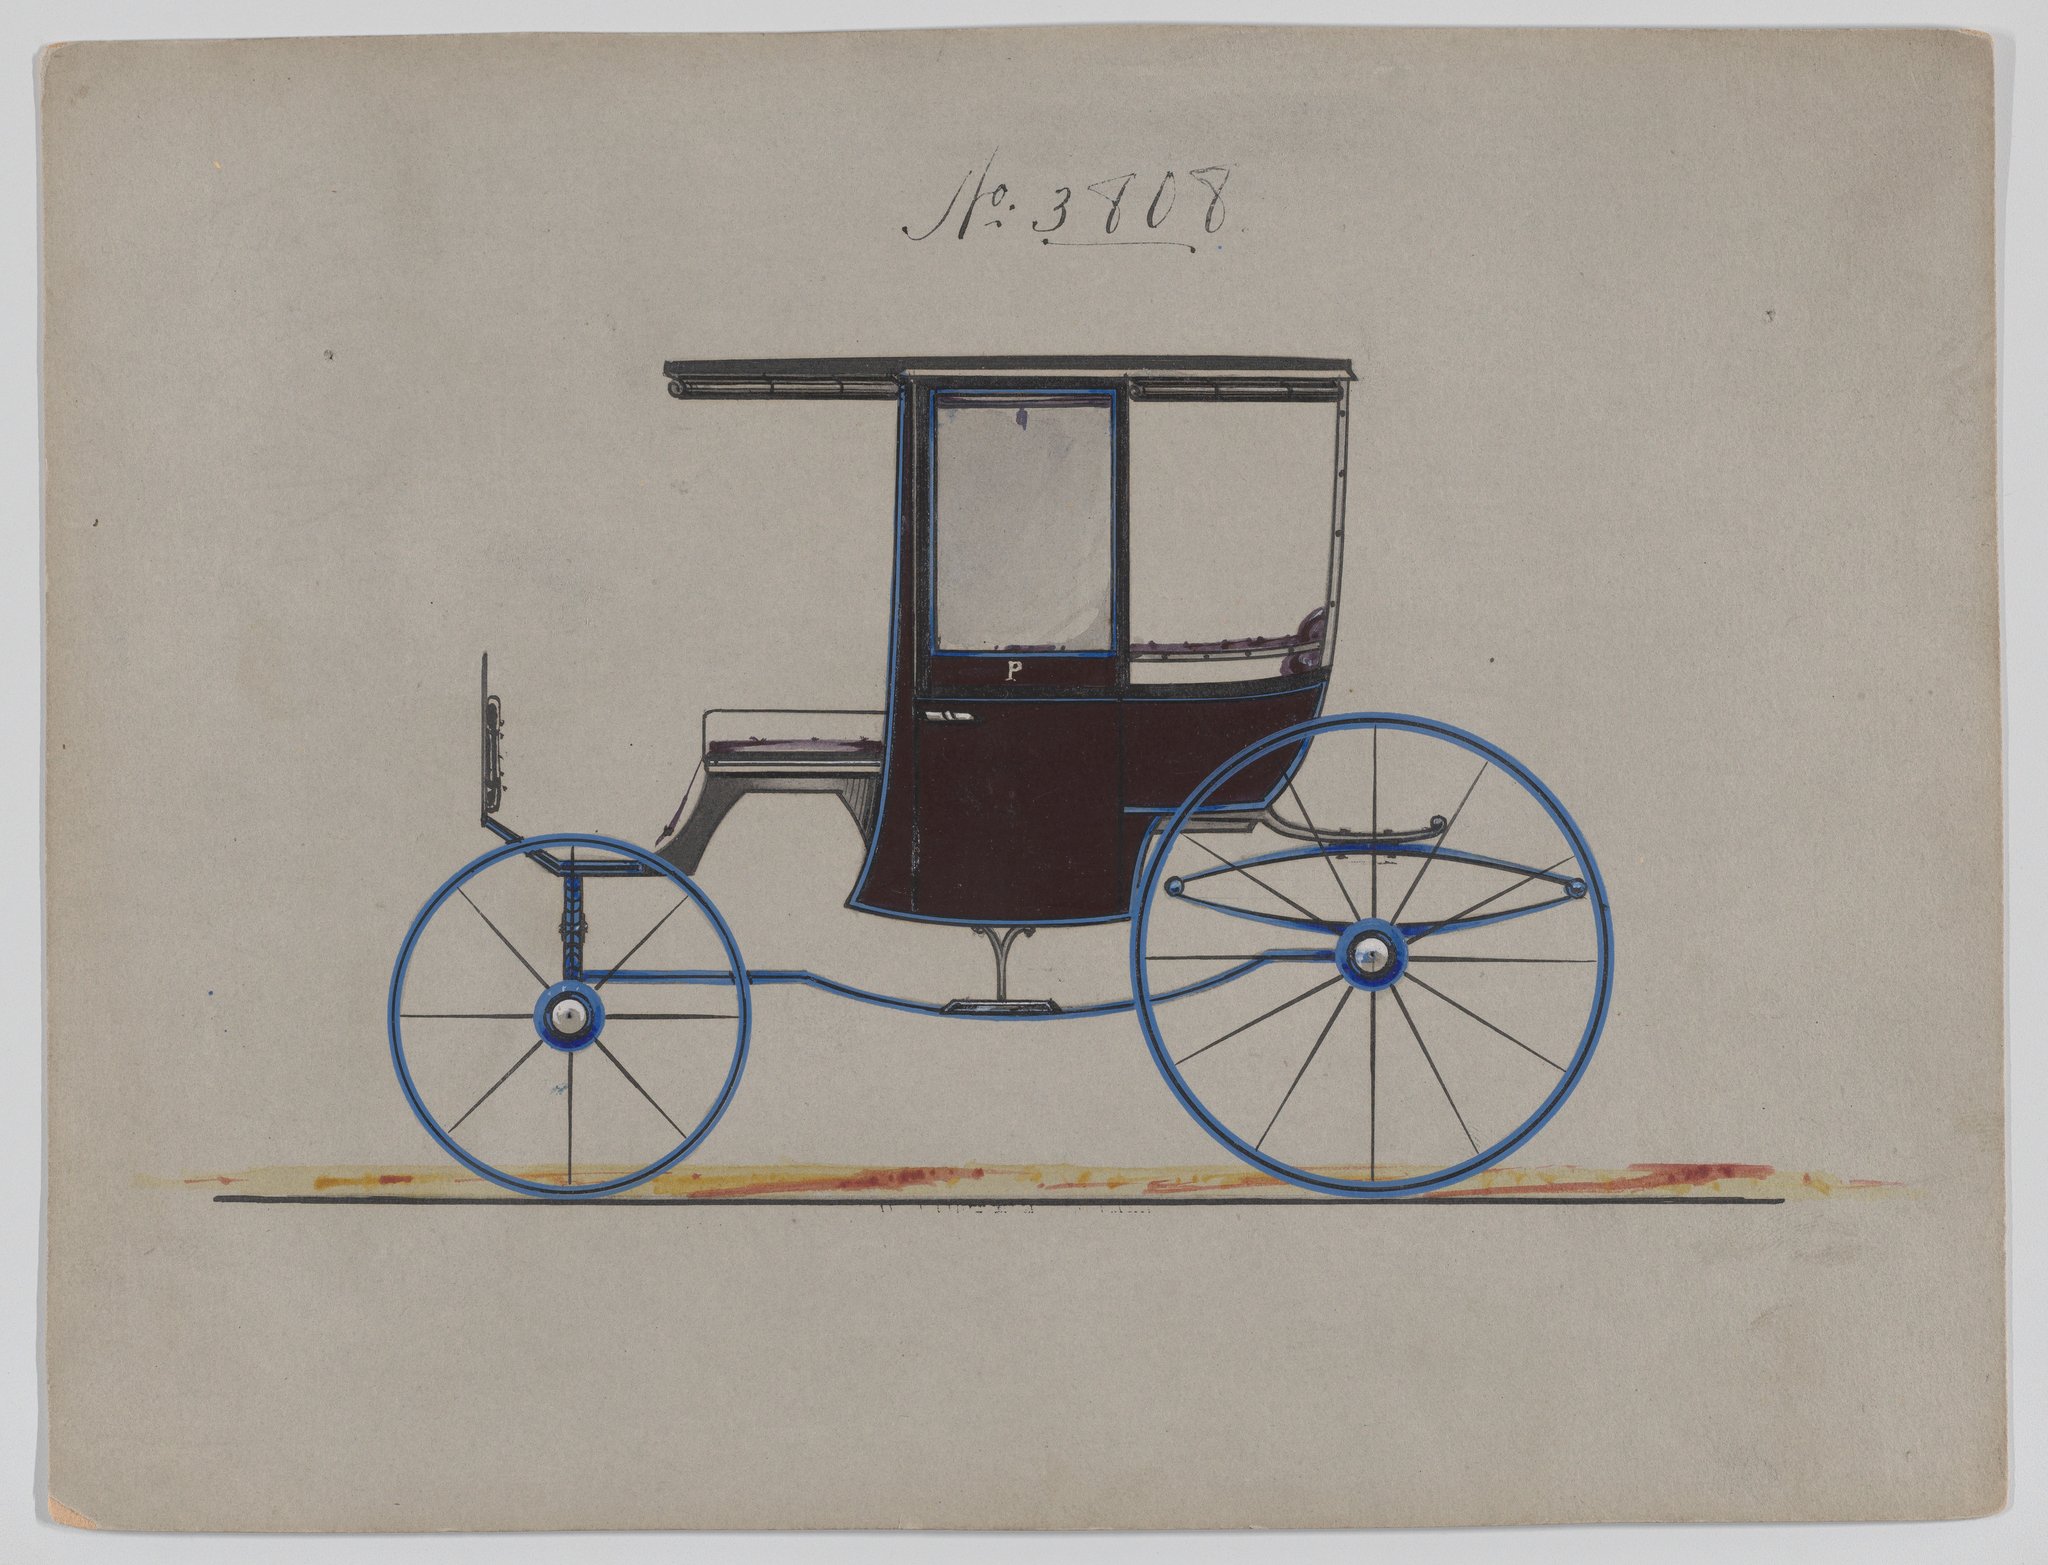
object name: drawing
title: Design for 4 seat Rockaway, no. 3808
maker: brewster & co.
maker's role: manufacturer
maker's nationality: american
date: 1883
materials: gouache, gum arabic, ink, watercolor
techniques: pen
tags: carriages